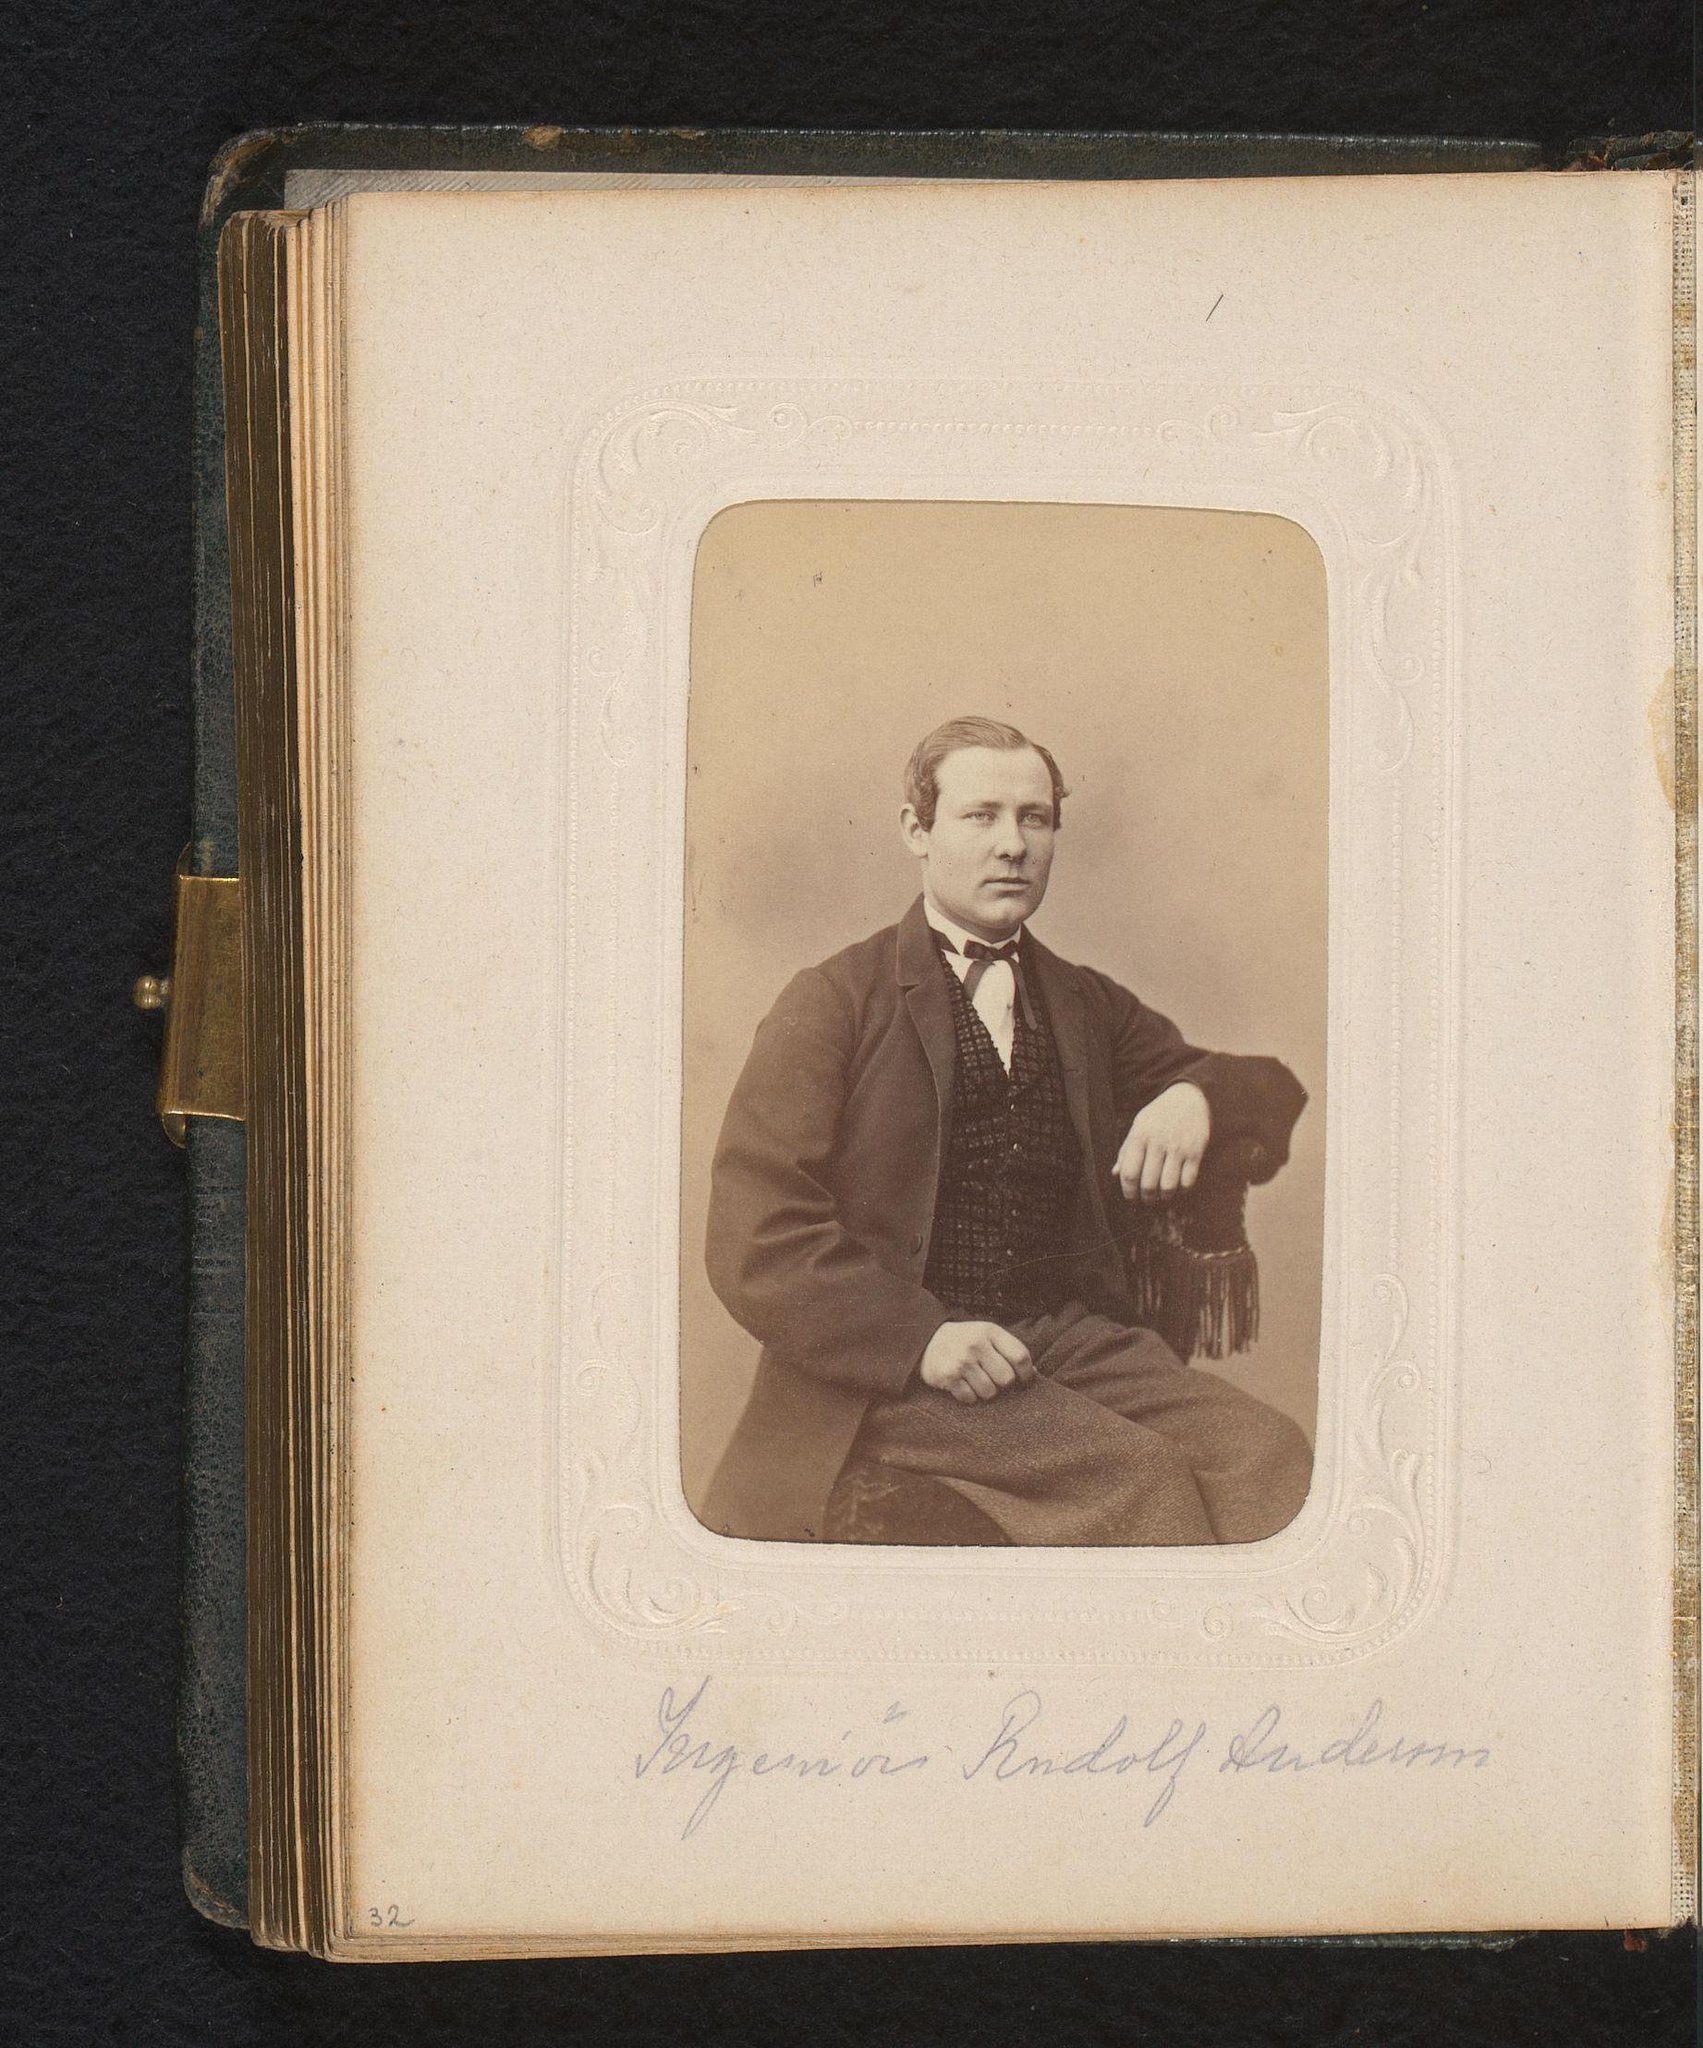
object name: photograph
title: Portret van een zittende man, aangeduid als Rudolf Andersson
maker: august roesler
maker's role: fotograaf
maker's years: 1837-1896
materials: cardboard, photographic support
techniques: albumen print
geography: stockholm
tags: sitting figure, historical persons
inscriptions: name: ‘Ingeniör Rudolf Andersson’, inscription: ‘AUGUST ROESLER/ Drottninggatan No 23/ STOCKHOLM/ samma hus som/ Apotheket Morian.’, annotation: ‘Ingeniör Rudolf Andersson/ New York.’